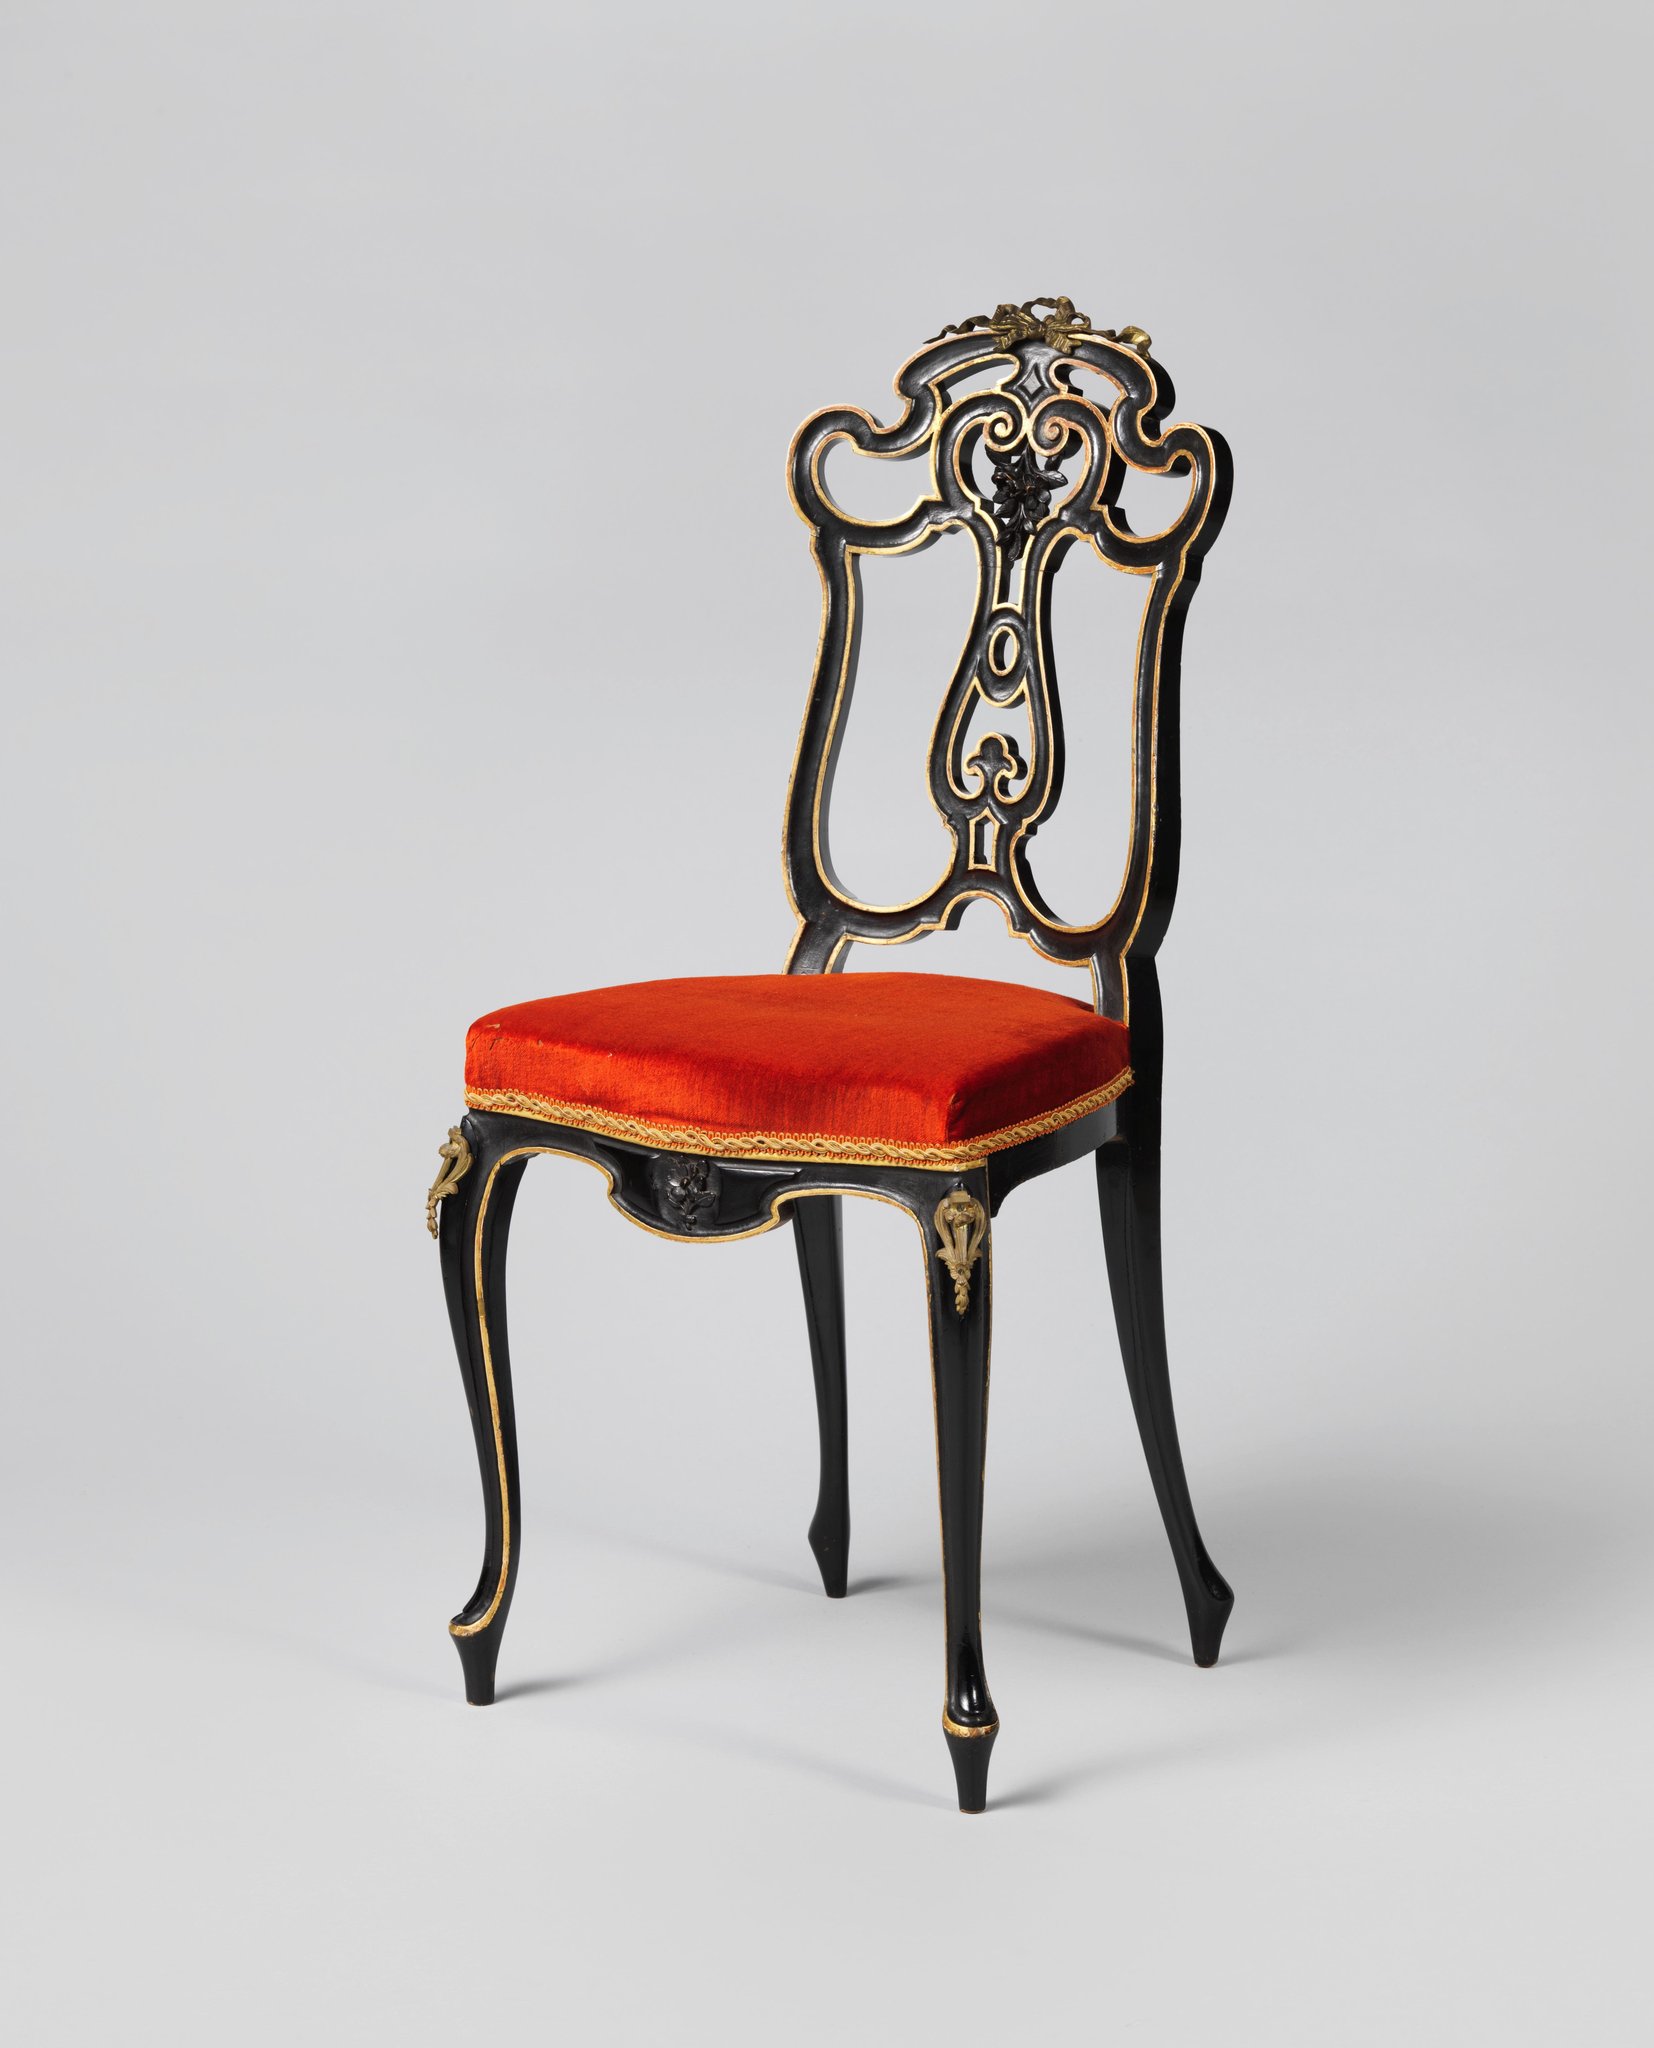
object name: furniture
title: Stoel, afwisselend glanzend en dof zwart geschilderd en versierd met vergulde randen en enkele goudkleurige beslagstukjes. Bekleed met oranje velours.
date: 1865-1875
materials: pigment, brass, textile, wood, wool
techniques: gilding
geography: northern netherlands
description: Chair. Wood painted black and gold. The Hague, c. 1870, by the Horrix Brothers.